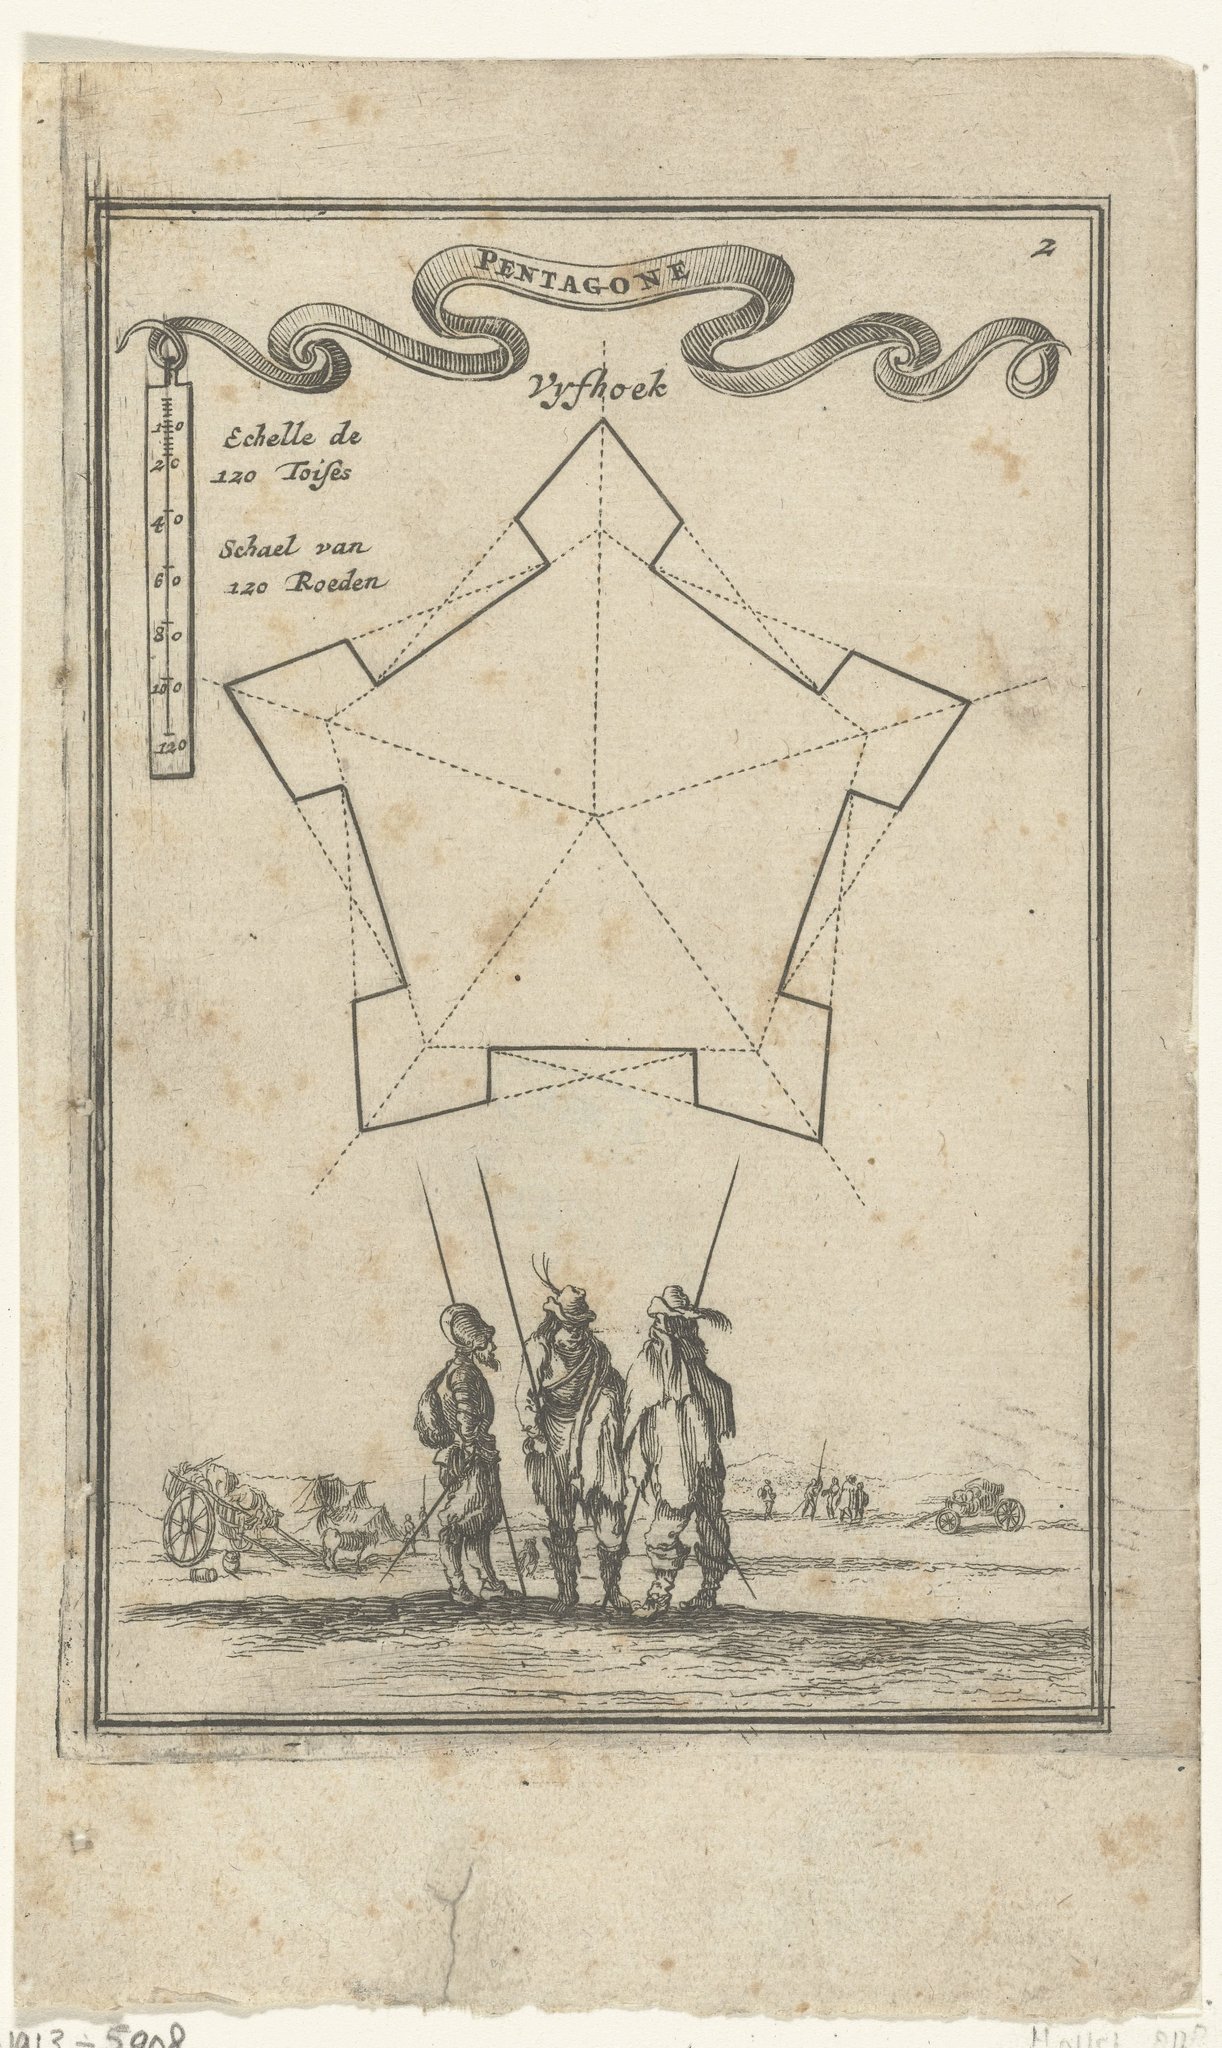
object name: print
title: Illustratie voor 'Den Arbeid van Mars' van Allain Manesson Mallet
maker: romeyn de hooghe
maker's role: draughtsman, goldsmith, painter, print maker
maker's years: 1645-1708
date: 1672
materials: paper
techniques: etching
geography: amsterdam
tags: fortifications, military engineering, the soldier; the soldier's life, mathematics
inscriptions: collector's mark: Lugt 2228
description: Grondplan voor een vesting, fort of versterking (vijfhoek). Daaronder drie soldaten. In de hoek rechtsboven het cijfer 2 (= het nummer van de pagina in het boek waartegenover de illustratie geplaatst is).